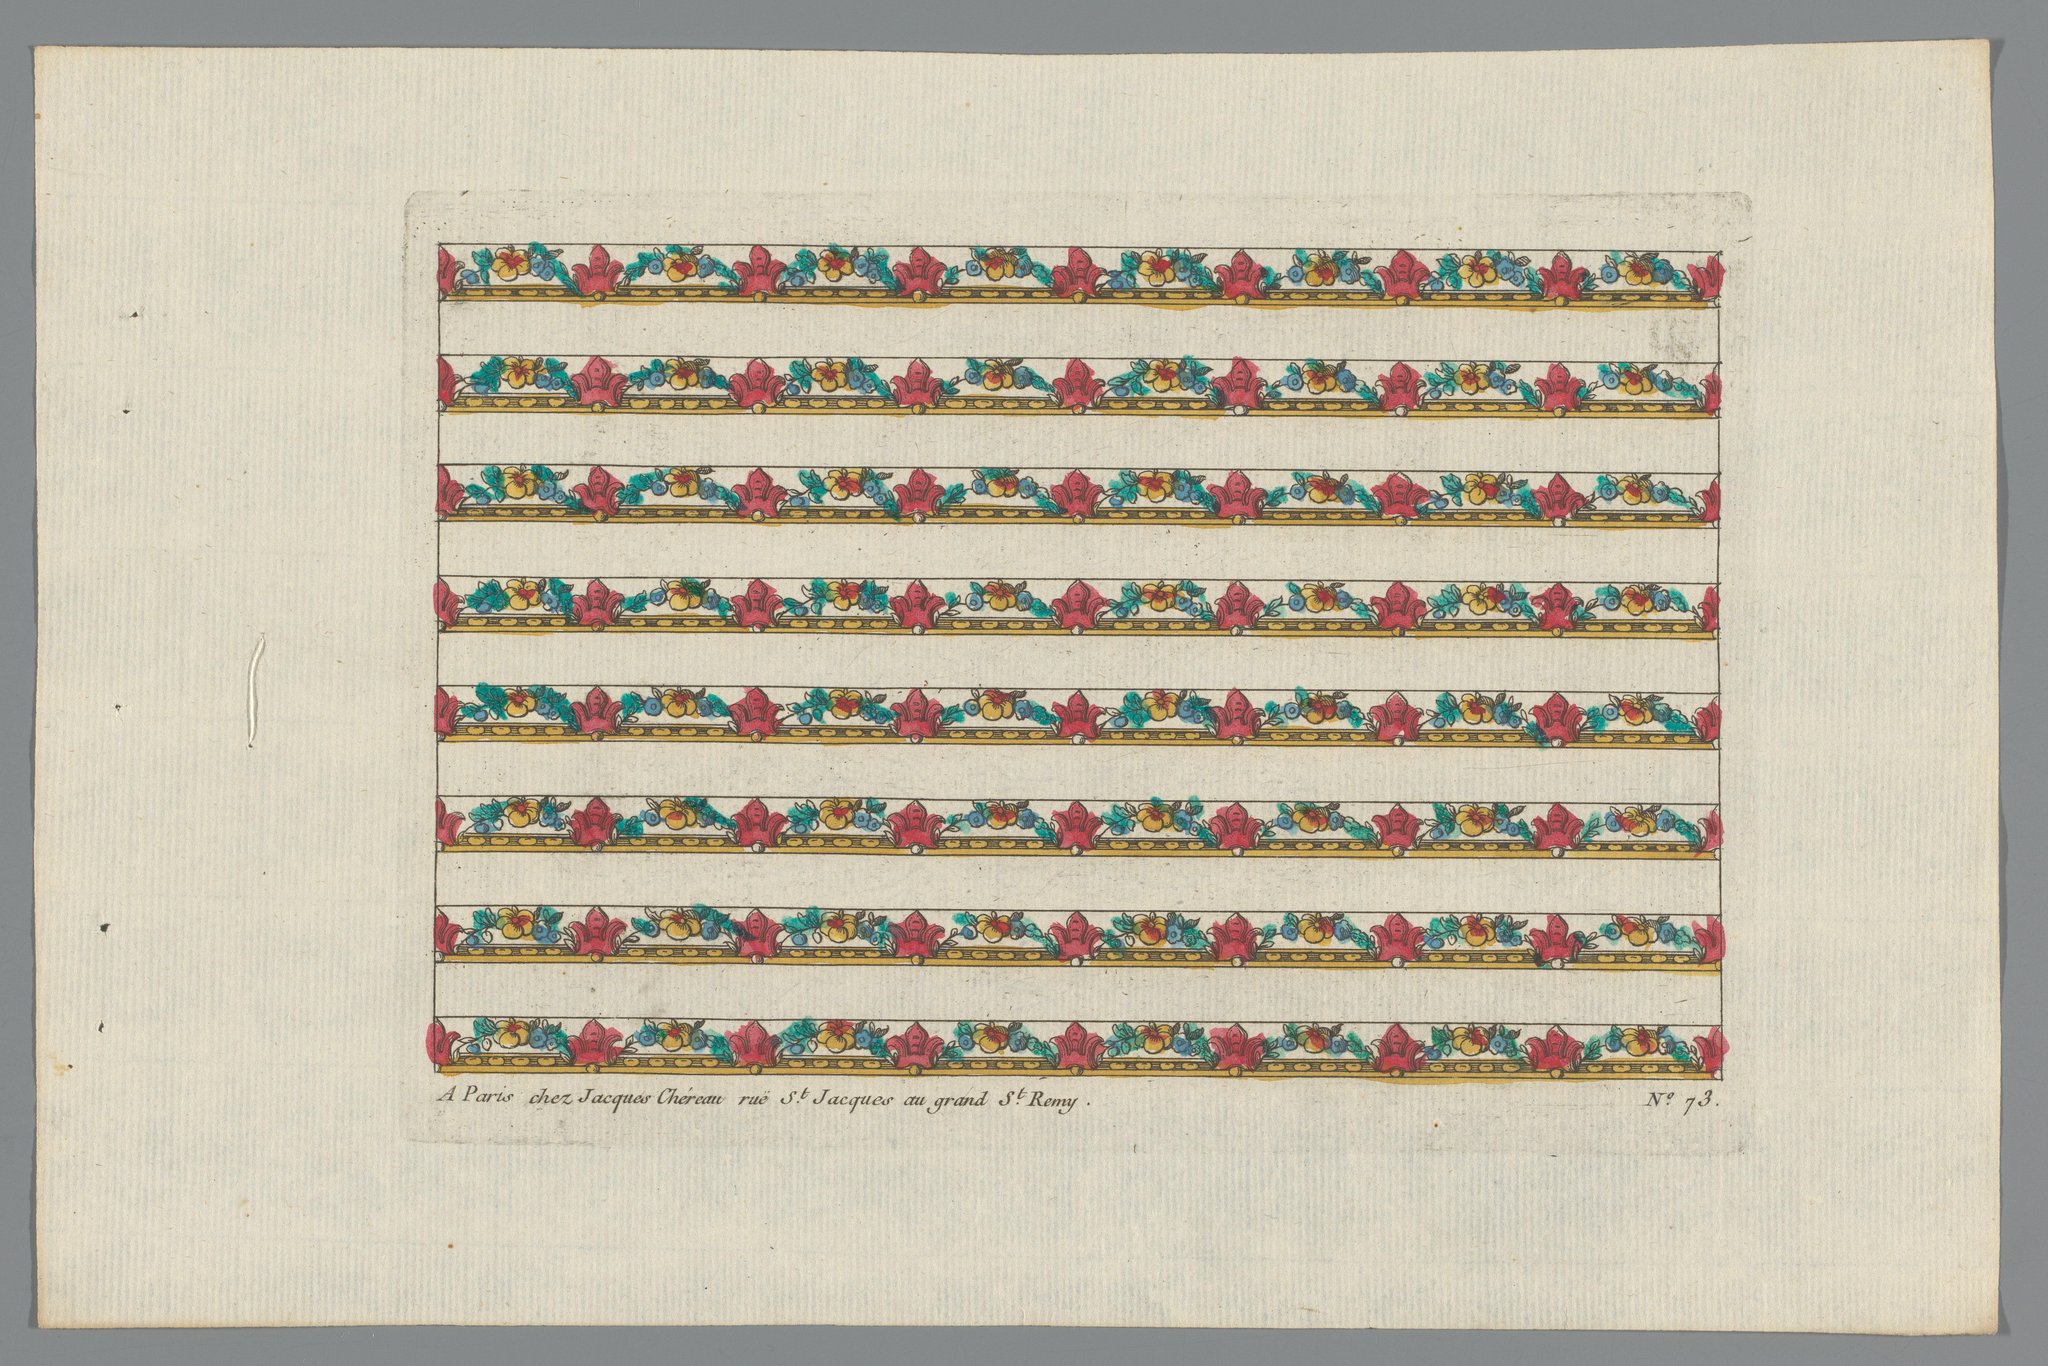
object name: print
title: Bladen met knipplaatjes en decoratieve randen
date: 1750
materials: paper, watercolor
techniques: etching, hand coloring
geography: paris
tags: ornament derived from plant forms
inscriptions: collector's mark: Lugt 2228, collector's mark: Lugt 2760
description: Blad met acht identieke decoratieve randen. Rechtsonder genummerd: 73. Een van 39 bladen met knipplaatjes en decoratieve randen.